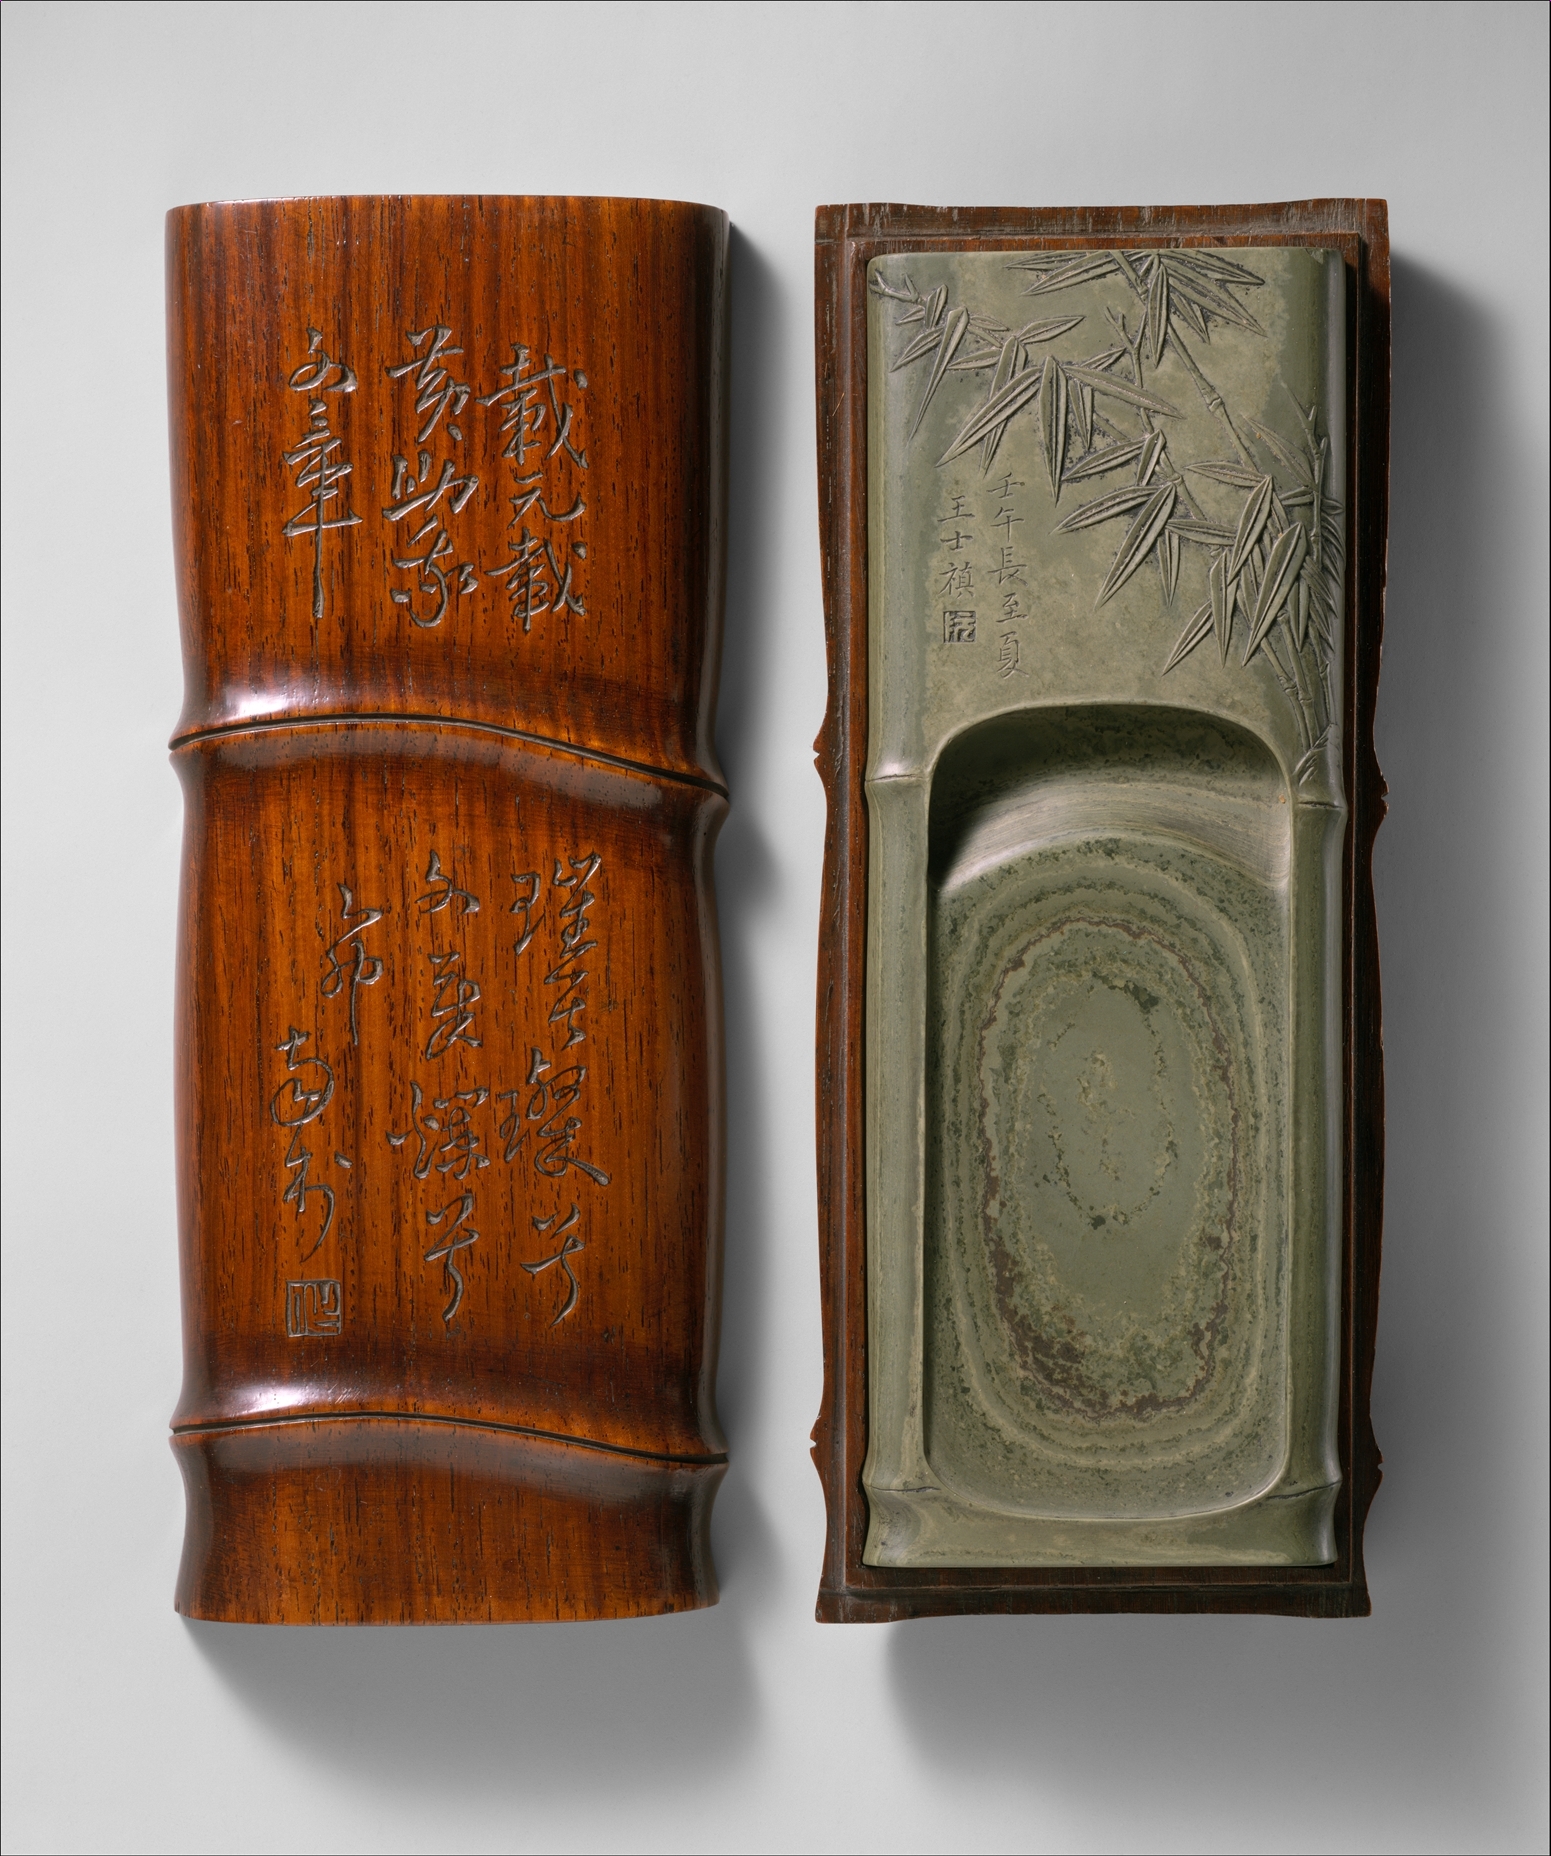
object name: inkstone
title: Inkstone with Bamboo Design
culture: chinese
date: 1767-1800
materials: stone, wood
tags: bamboo